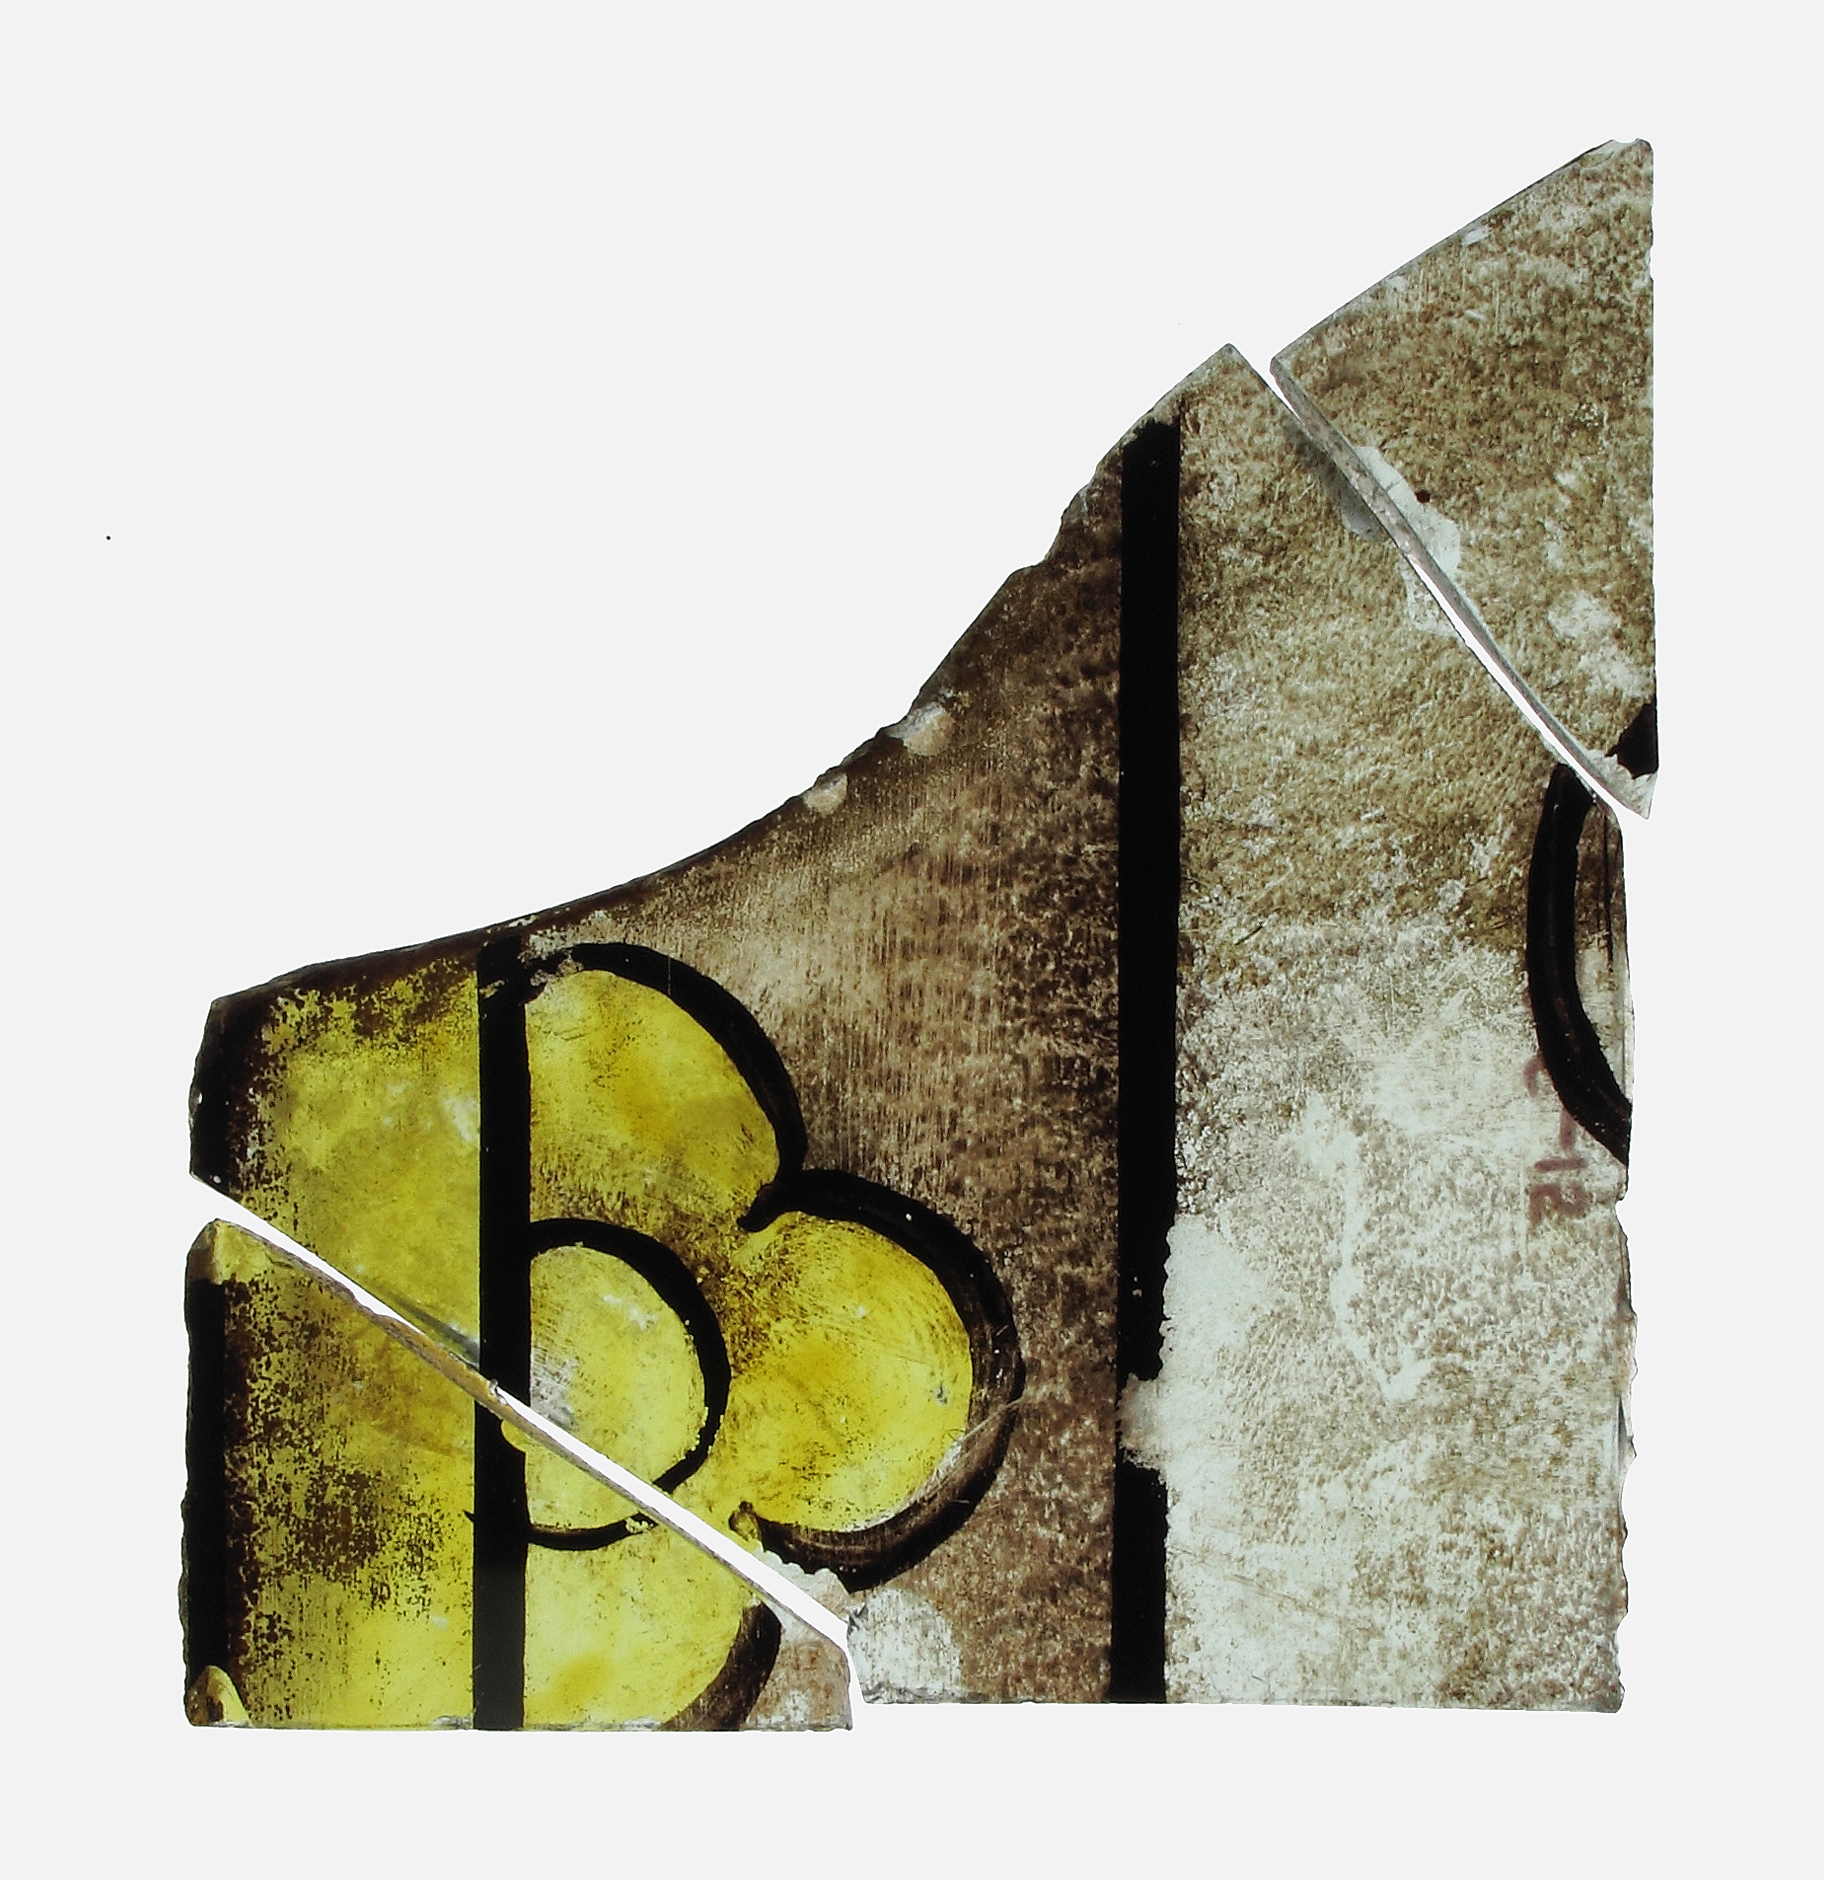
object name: fragment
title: Glass Fragment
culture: french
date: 1501-1600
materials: glass